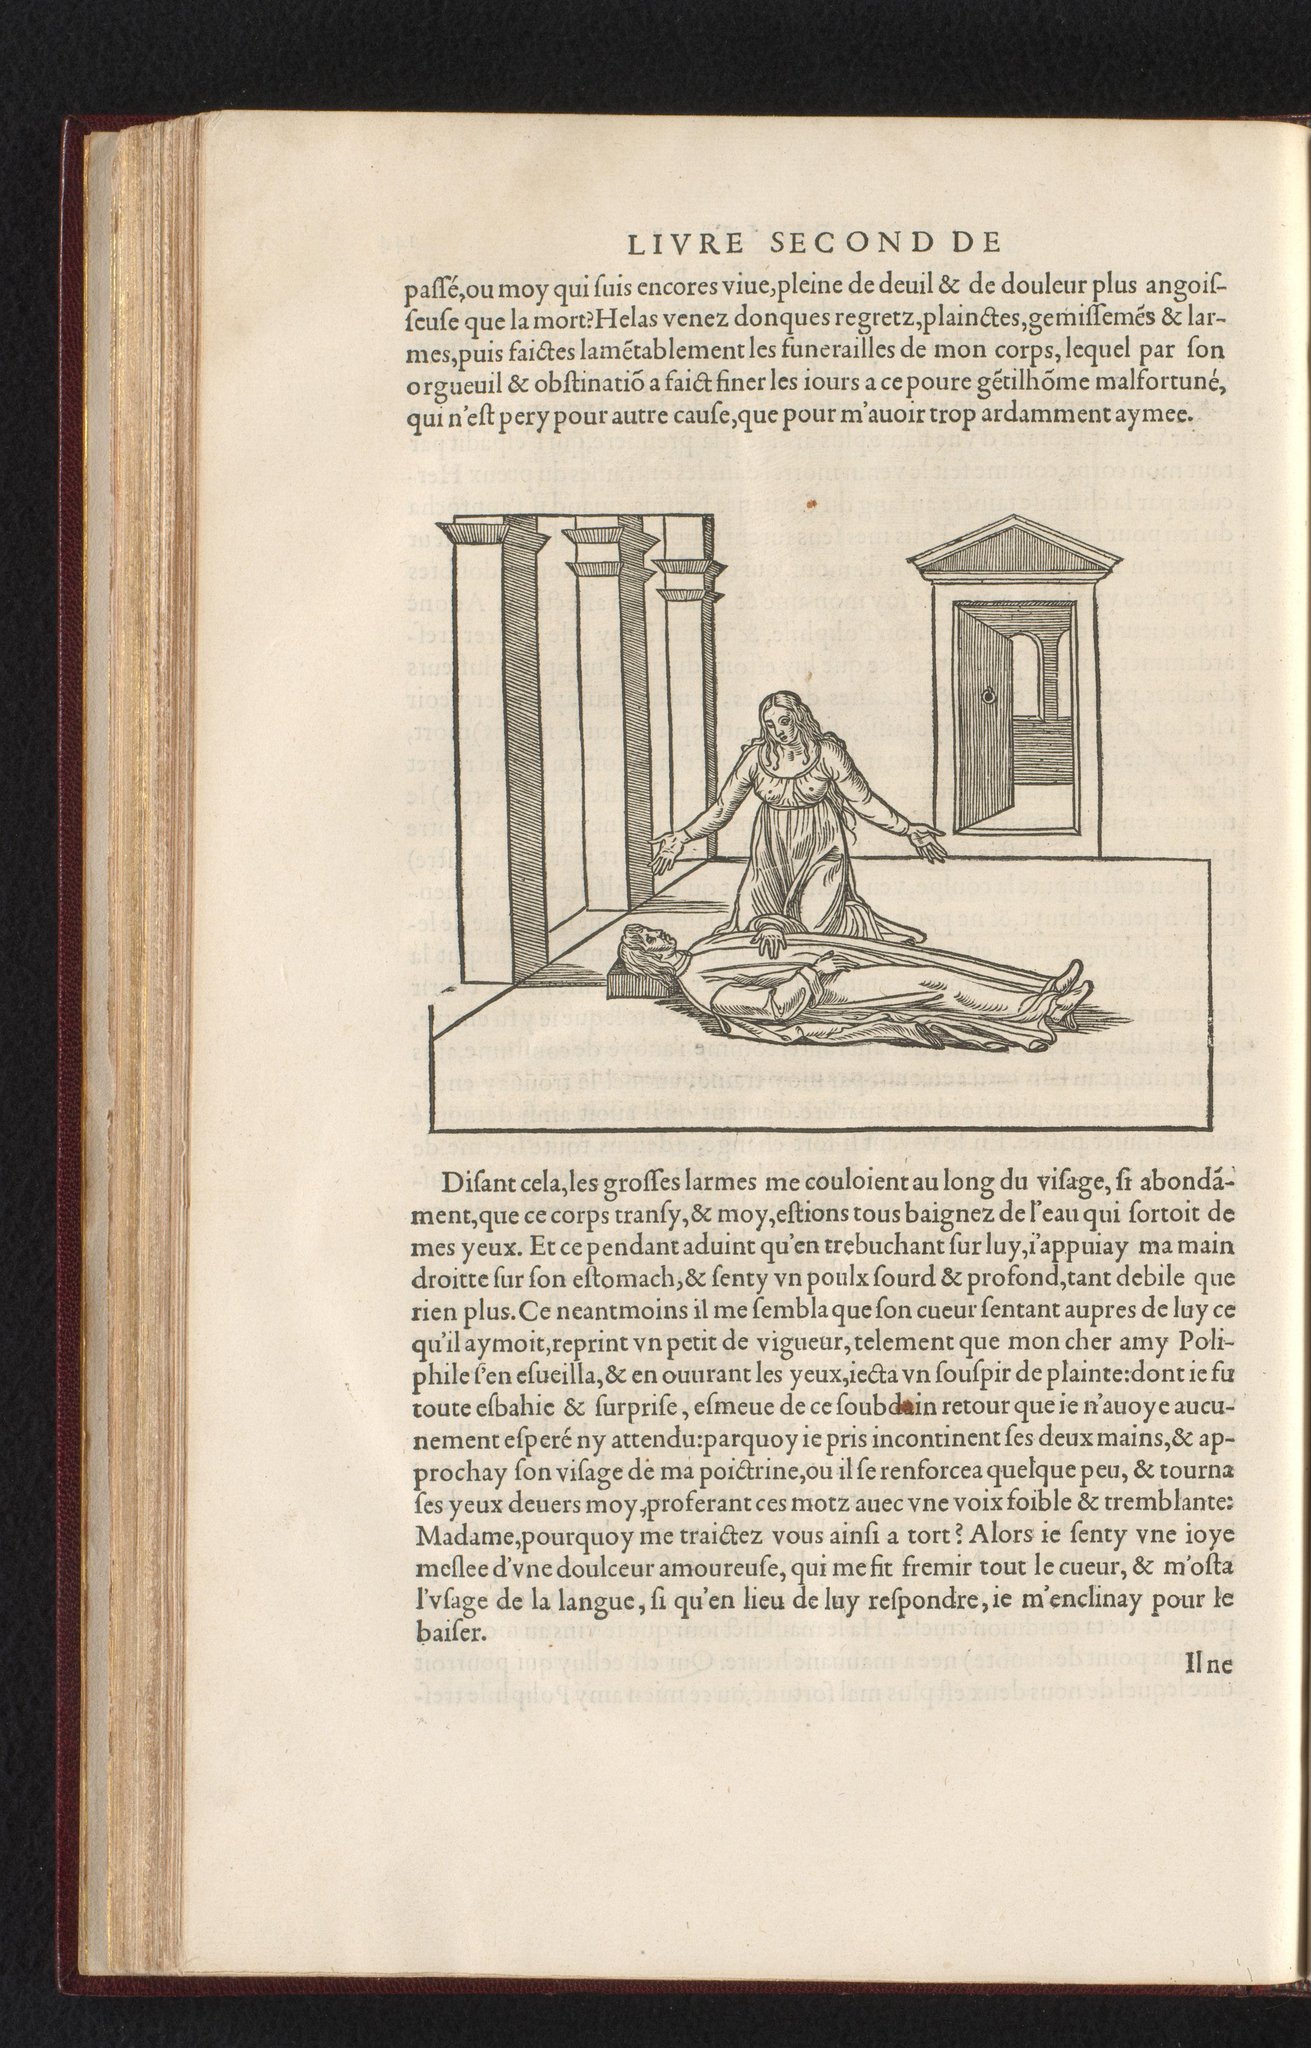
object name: print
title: Polia bij het lichaam van Poliphilo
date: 1546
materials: paper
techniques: letterpress printing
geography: paris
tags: (scenes from) specific works of literature: colonna, hypnerotomachia poliphili, the corpse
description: Prent uit: Colonna, Francesco. Hypnerotomachie ou discours du songe de Poliphile, deduisant comme amour le combat a l'occasion de Polia. Parijs: Jacques Kerver, 1546, verso fol. 144.